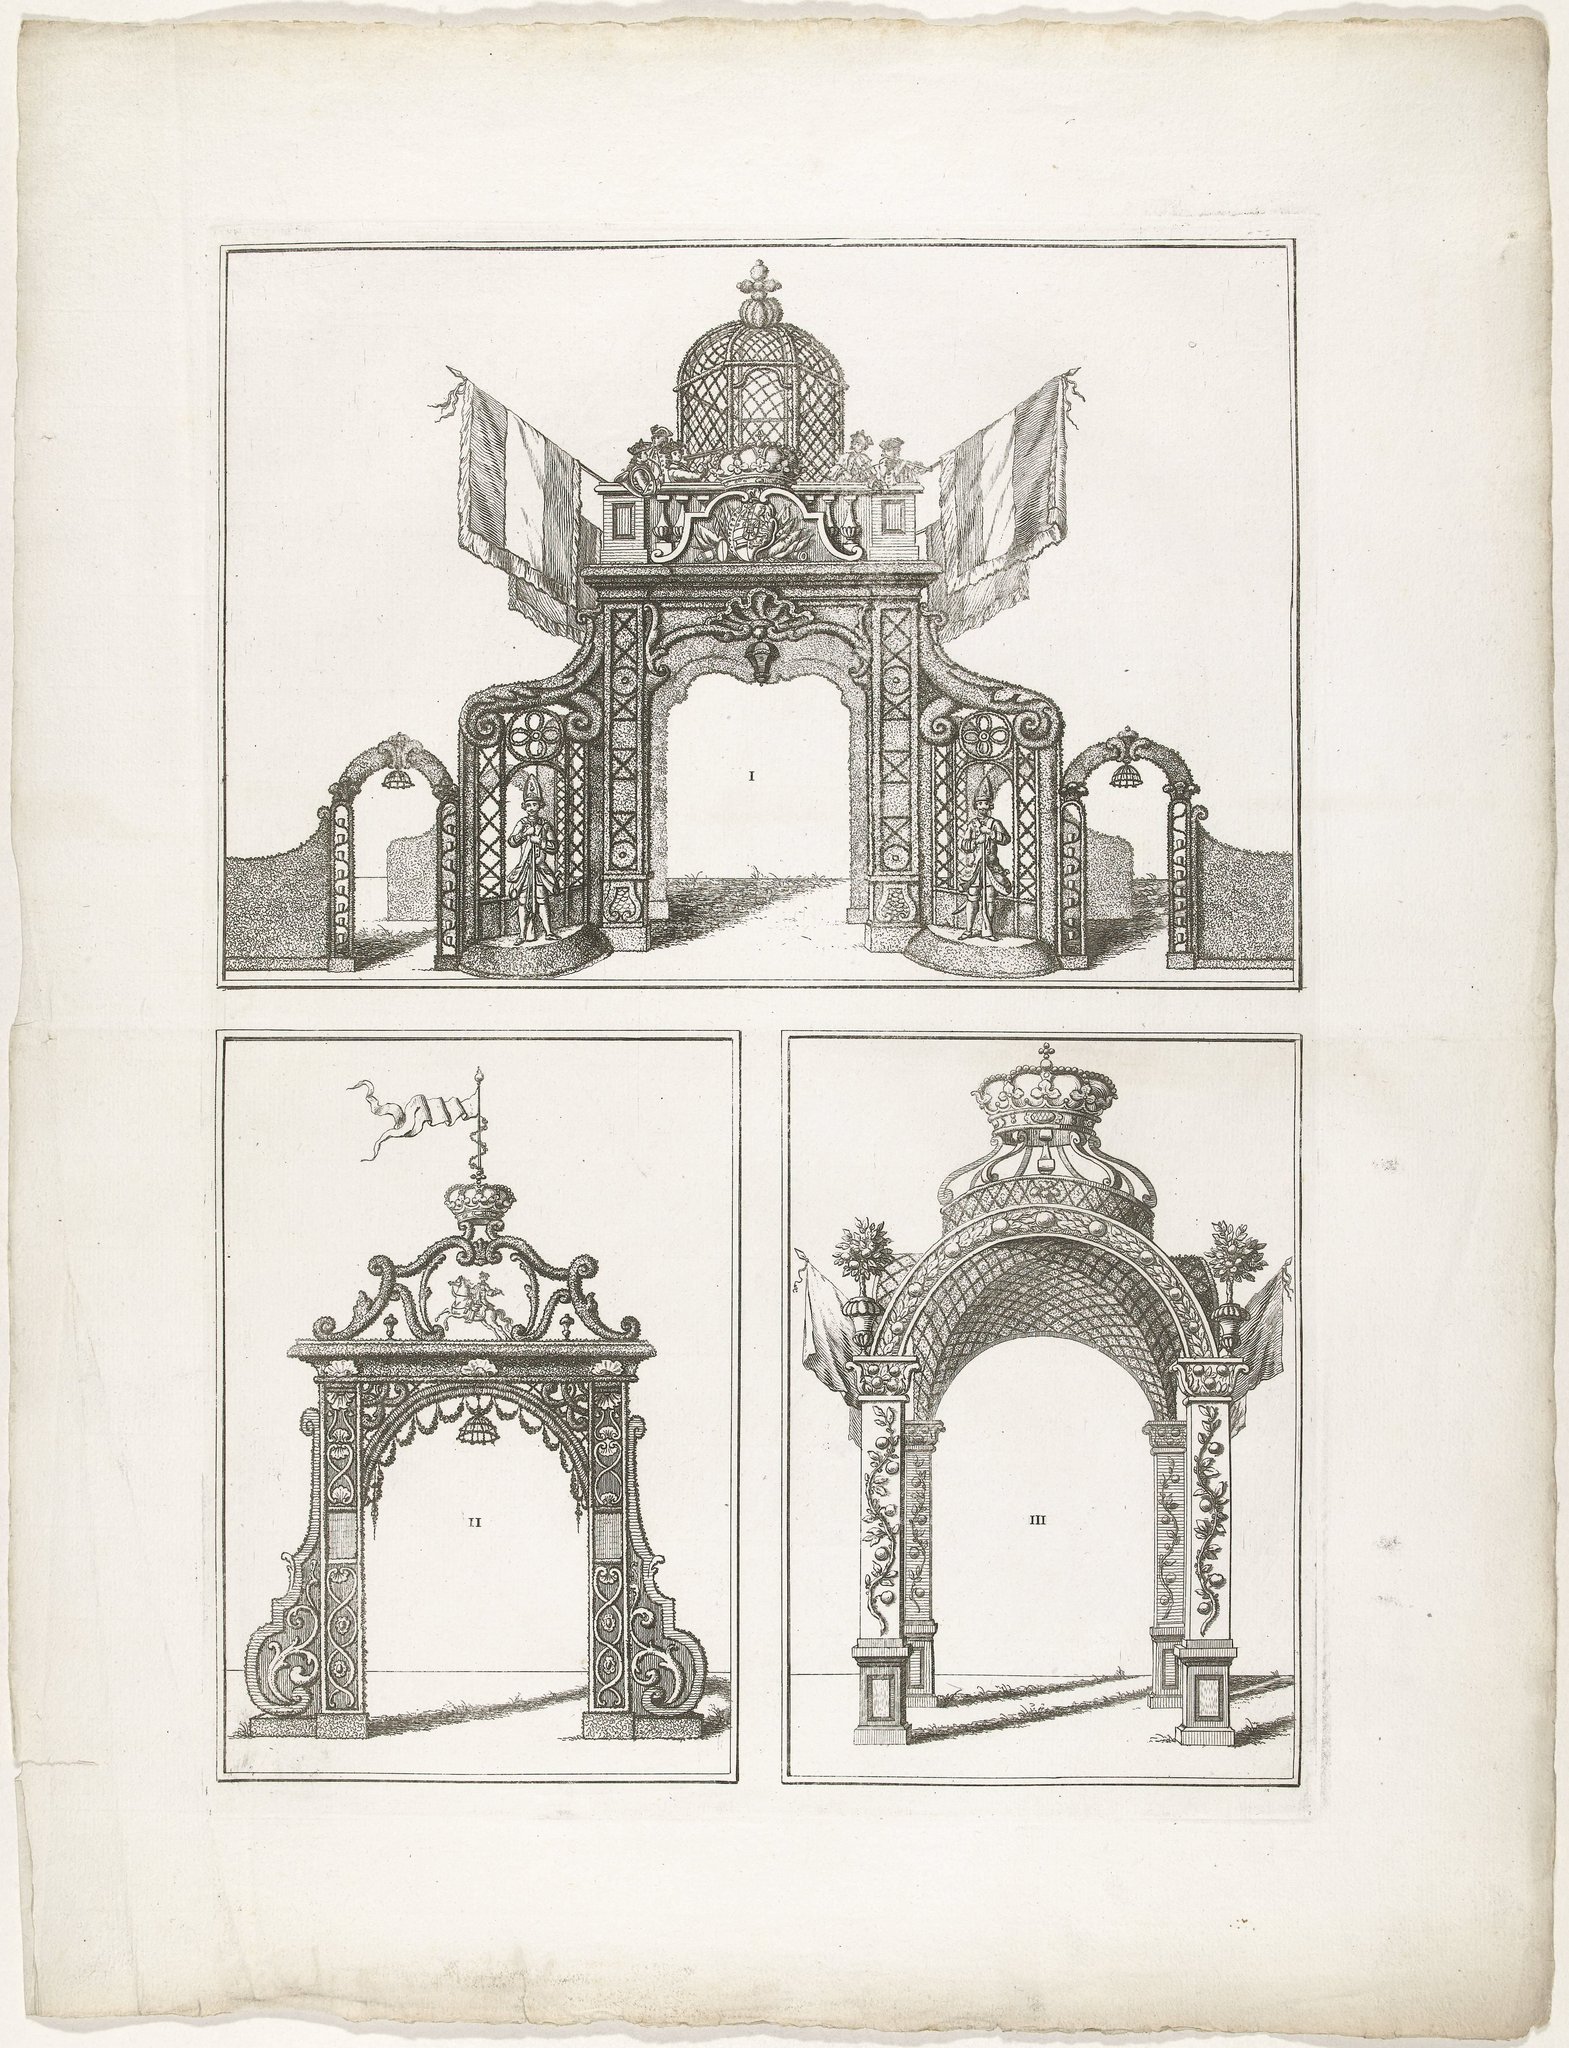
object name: print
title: Erepoorten I-III te Den Haag, 1747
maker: albertus frese (de jonge)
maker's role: draughtsman, painter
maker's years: 1714-1788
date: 1766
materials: paper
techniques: etching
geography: the hague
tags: the hague, willem iv (prins van oranje-nassau), triumphal arch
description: Blad met de erepoorten genummerd I-III. Los blad oorspronkelijk onderdeel van het plaatwerk Nette afbeelding en ampele beschrijving der eere-poorten uit 1766 met voorstellingen van de erepoorten en triomfbogen opgesteld te Den Haag tijdens de feestelijkheden rond de intrede van prins Willem IV als stadhouder van Holland en West-Friesland op 6 juni 1747.